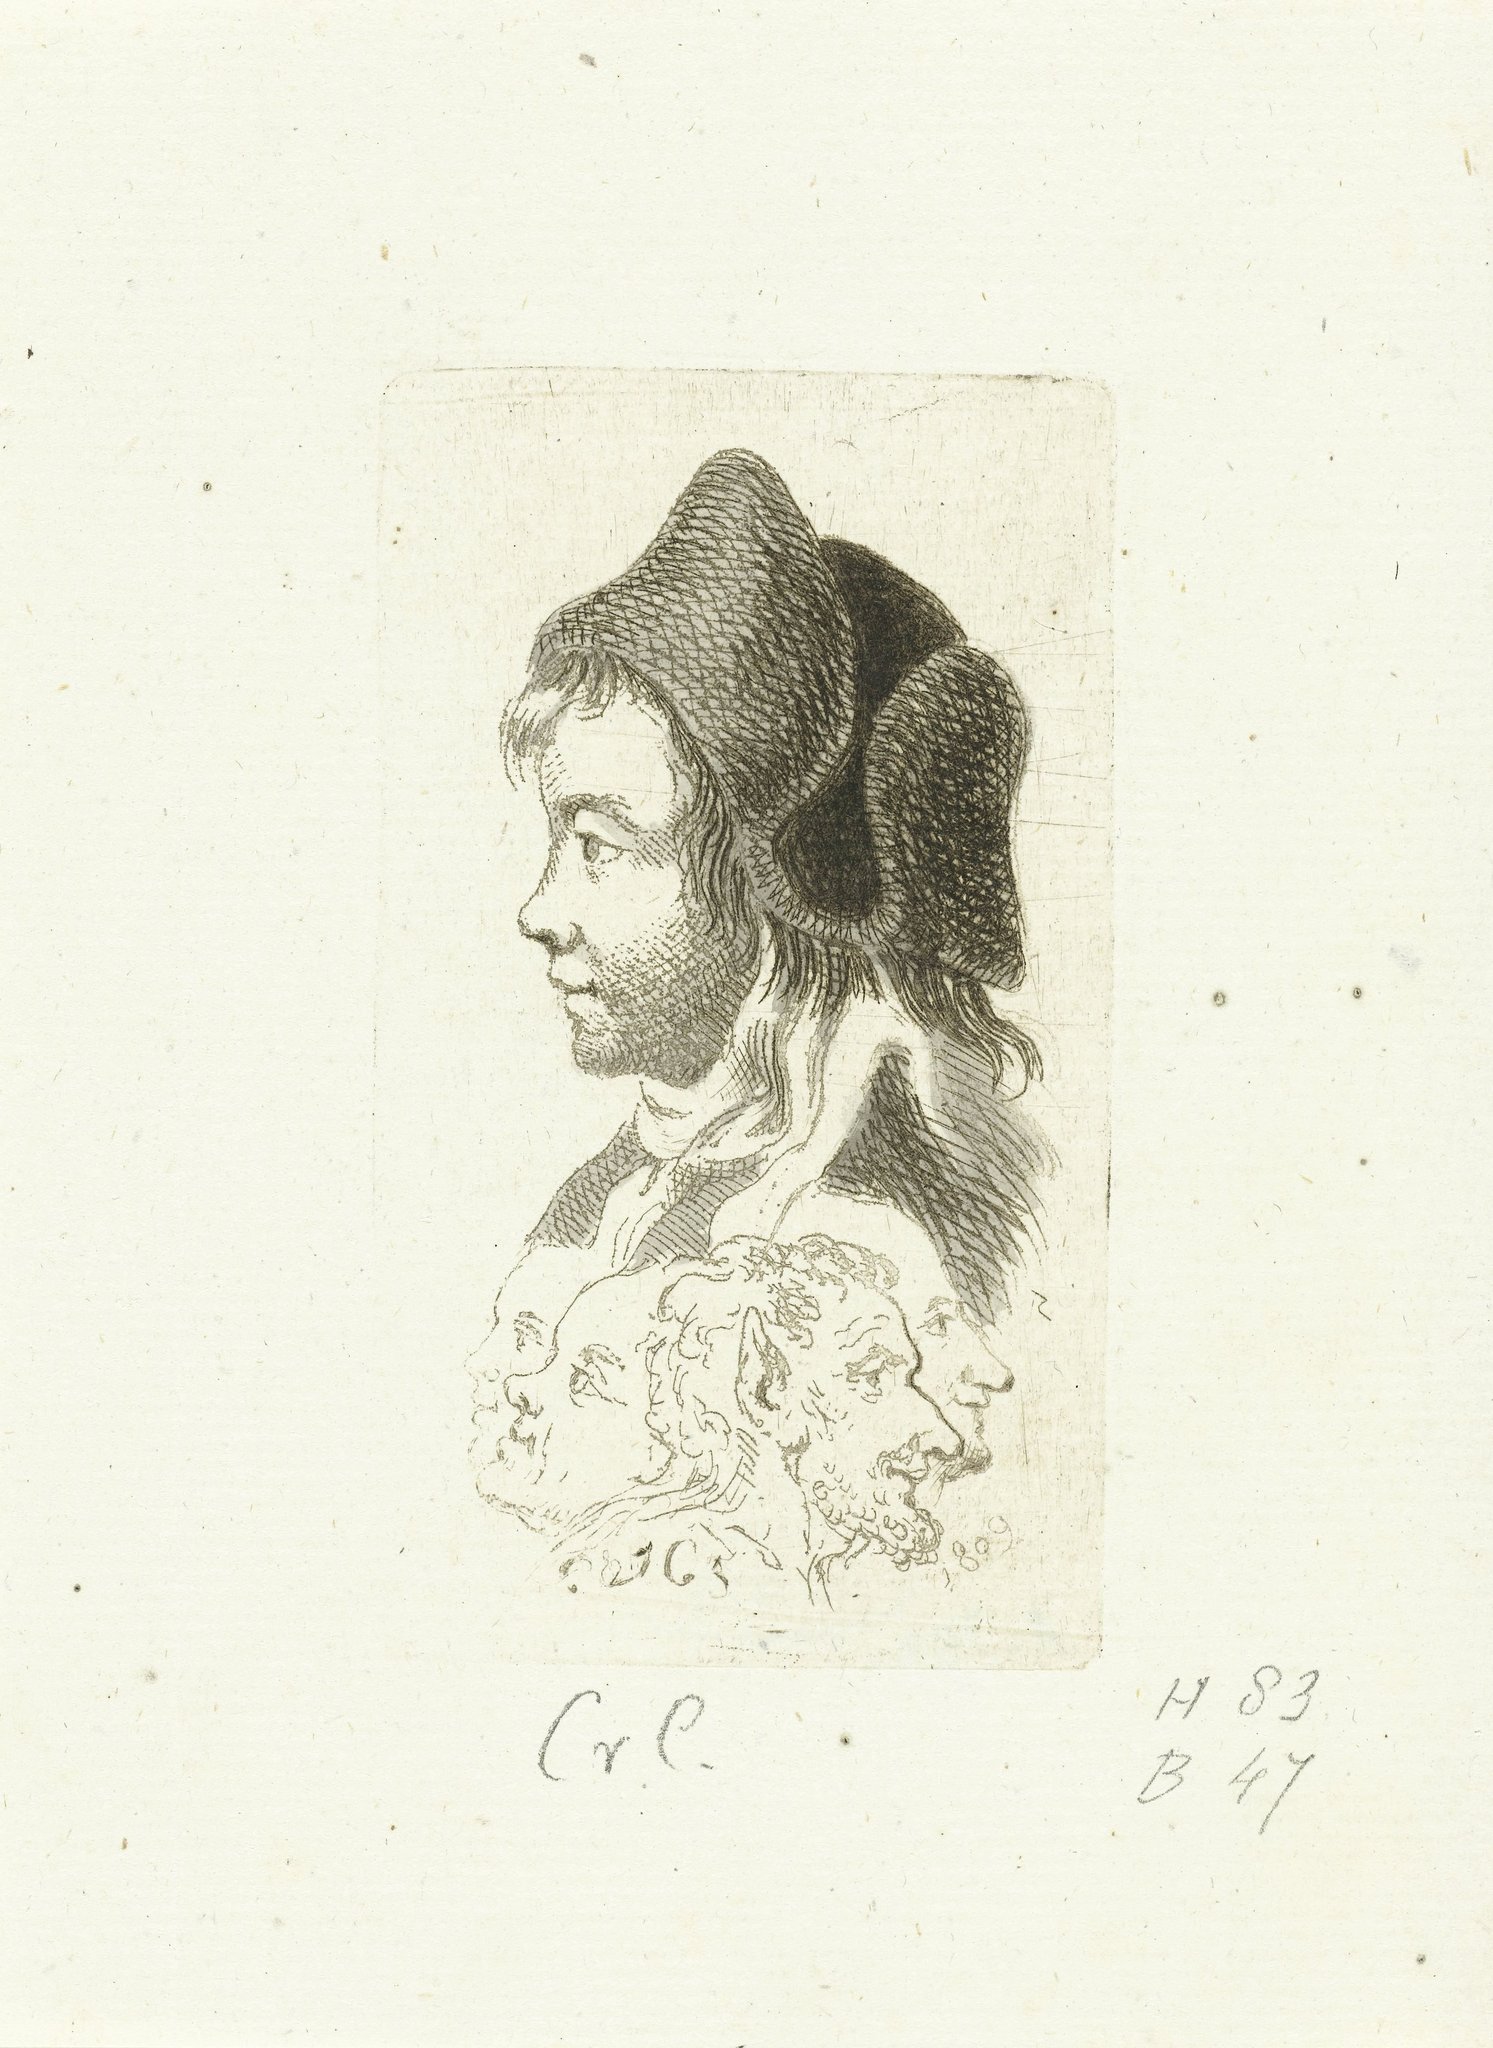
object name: print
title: Jongen met steek op het hoofd en vier hoofden waaronder kop van sater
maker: johannes van cuylenburgh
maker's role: print maker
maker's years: 1793-1841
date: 1809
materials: paper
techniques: etching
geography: netherlands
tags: boy (child between toddler and youth)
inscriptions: collector's mark: Lugt 2228